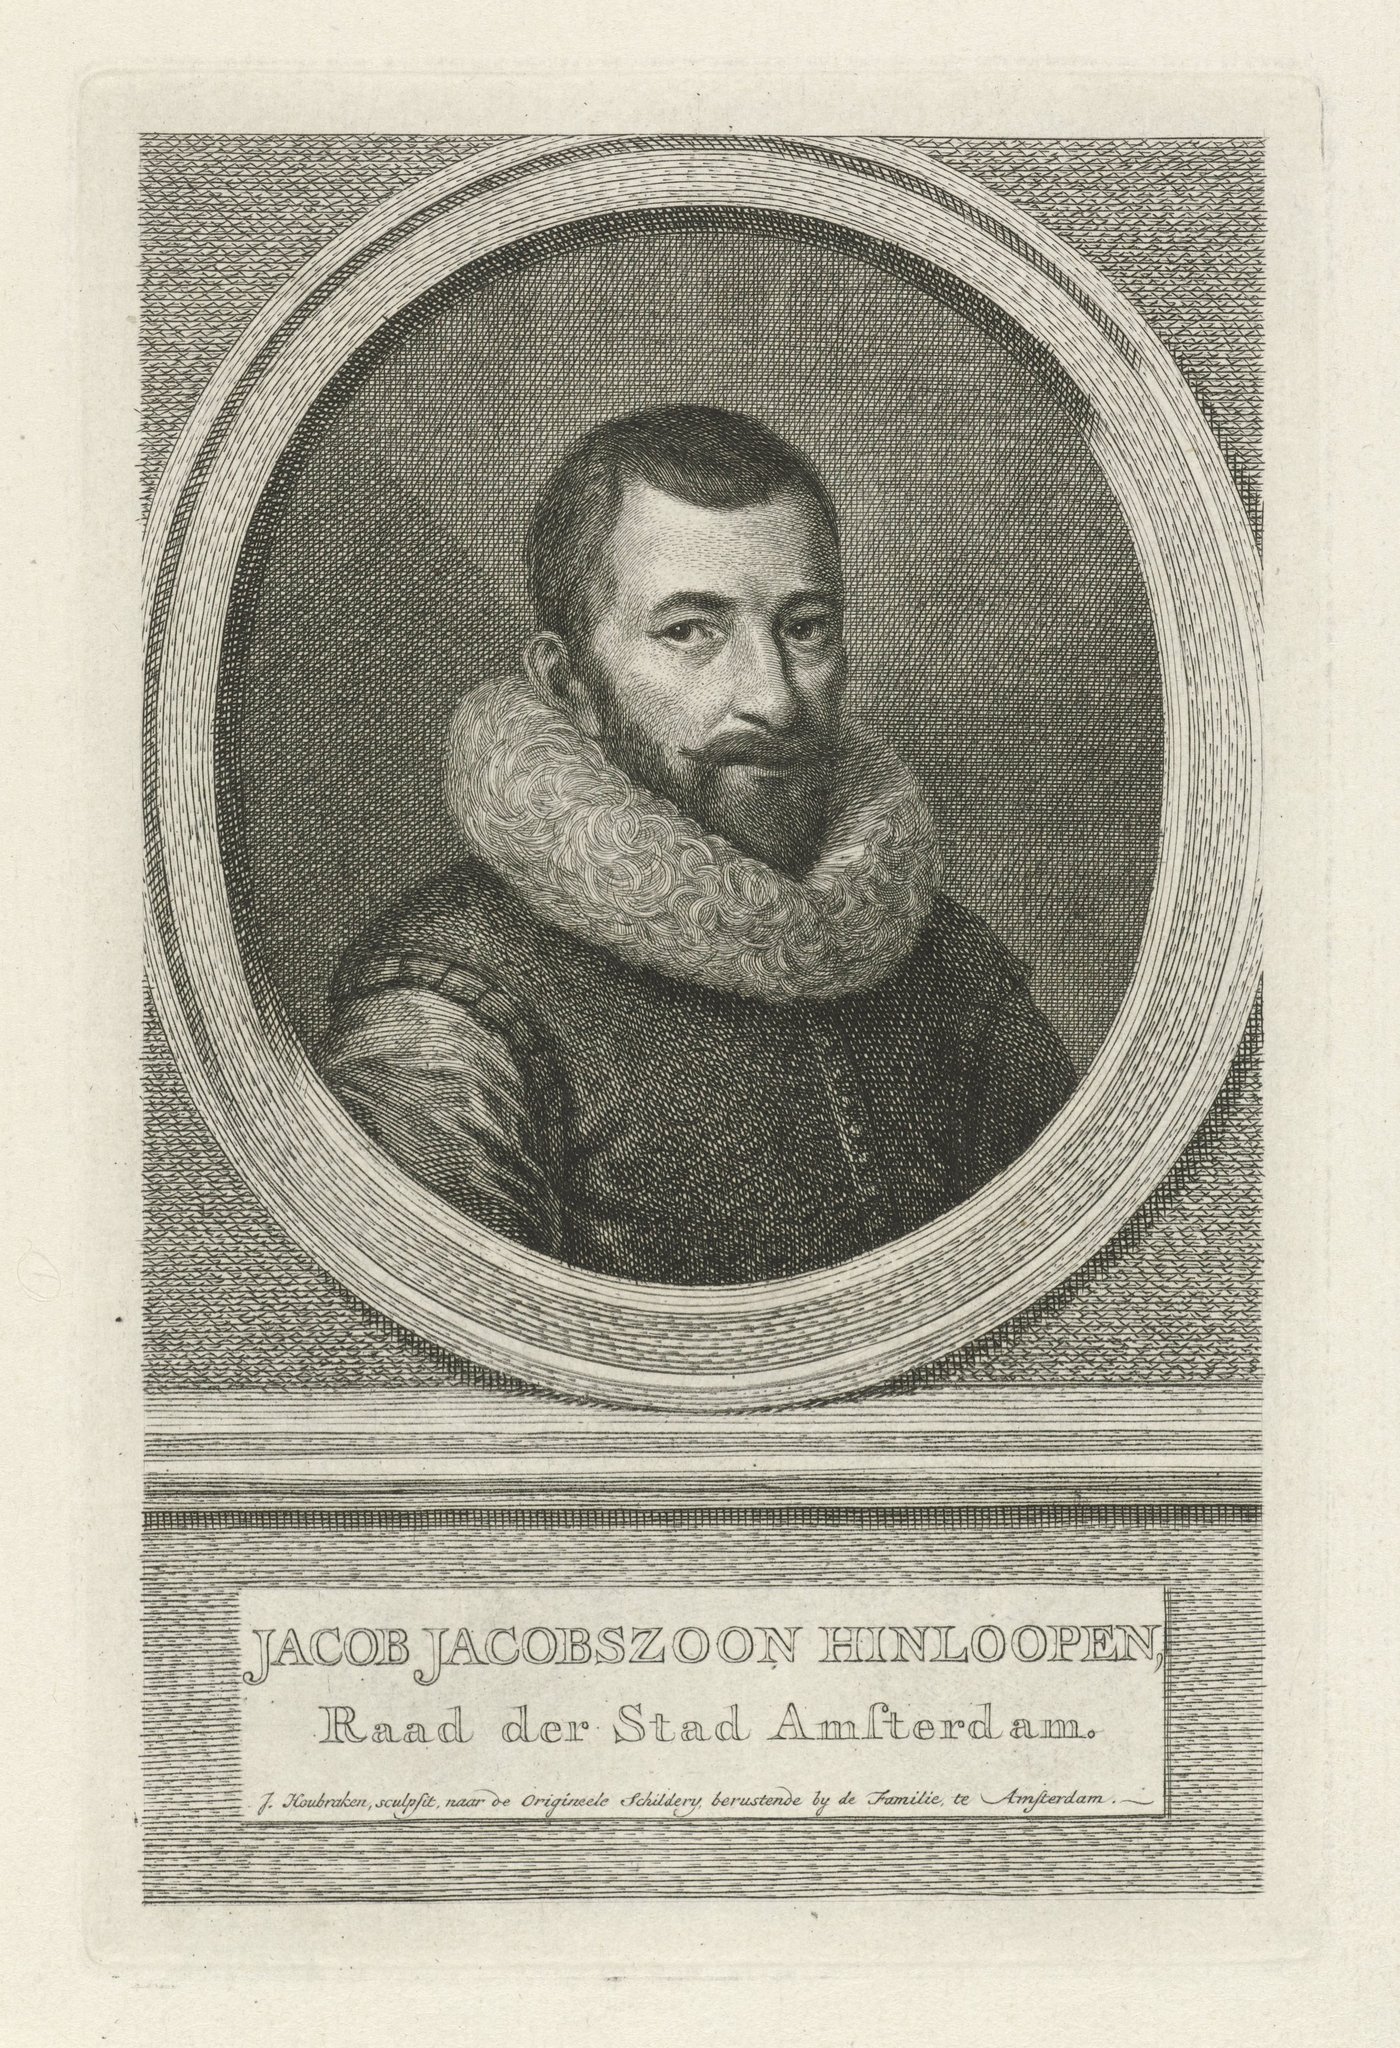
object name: print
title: Portret van Jacob Jacobszoon Hinlopen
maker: jacob houbraken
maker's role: draughtsman, print maker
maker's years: 1698-1780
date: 1749-1780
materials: paper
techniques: engraving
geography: amsterdam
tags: historical persons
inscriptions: collector's mark: Lugt 2165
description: Deze prent is oorspronkelijk bedoeld als aanvulling op Jan Wagenaars ‘Vaderlandsche historie’* en was zo vanaf 1796 verkrijgbaar bij Johannes Allart te Amsterdam. Voor de advertentie waarin Allart de 60 portretten en 7 platen, allen gegraveerd door Houbraken, ter aanvulling op Wagenaars ‘Vaderlandsche historie’ aanbiedt, zie RP-P-OB-77.766. *Van dit werk zijn in de achttiende eeuw meerdere uitgaves verschenen, zoals: Wagenaar, Jan. Vaderlandsche historie, vervattende de geschiedenissen der Vereenigde Nederlanden (…). 21 delen. Amsterdam: Isaak Tirion, 1749-1759. Wagenaar, Jan. Vaderlandsche historie, vervattende de geschiedenissen der nu Vereenigde Nederlanden (…). 21 delen. Amsterdam: weduwe Isaak Tirion, 1770. Wagenaar, Jan. Vaderlandsche historie, vervattende de geschiedenissen der nu Vereenigde Nederlanden (…). 21 delen. Amsterdam, Leiden, Dordrecht en Harlingen: P. Schouten e.a., 1782. Wagenaar, Jan. Vaderlandsche historie, vervattende de geschiedenissen der nu Vereenigde Nederlanden (…). 21 delen. Amsterdam: Johannes Allart, 1790-1796.